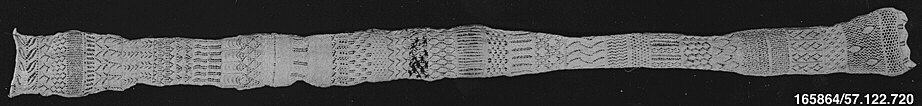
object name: sampler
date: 1801-1900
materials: cotton, lace